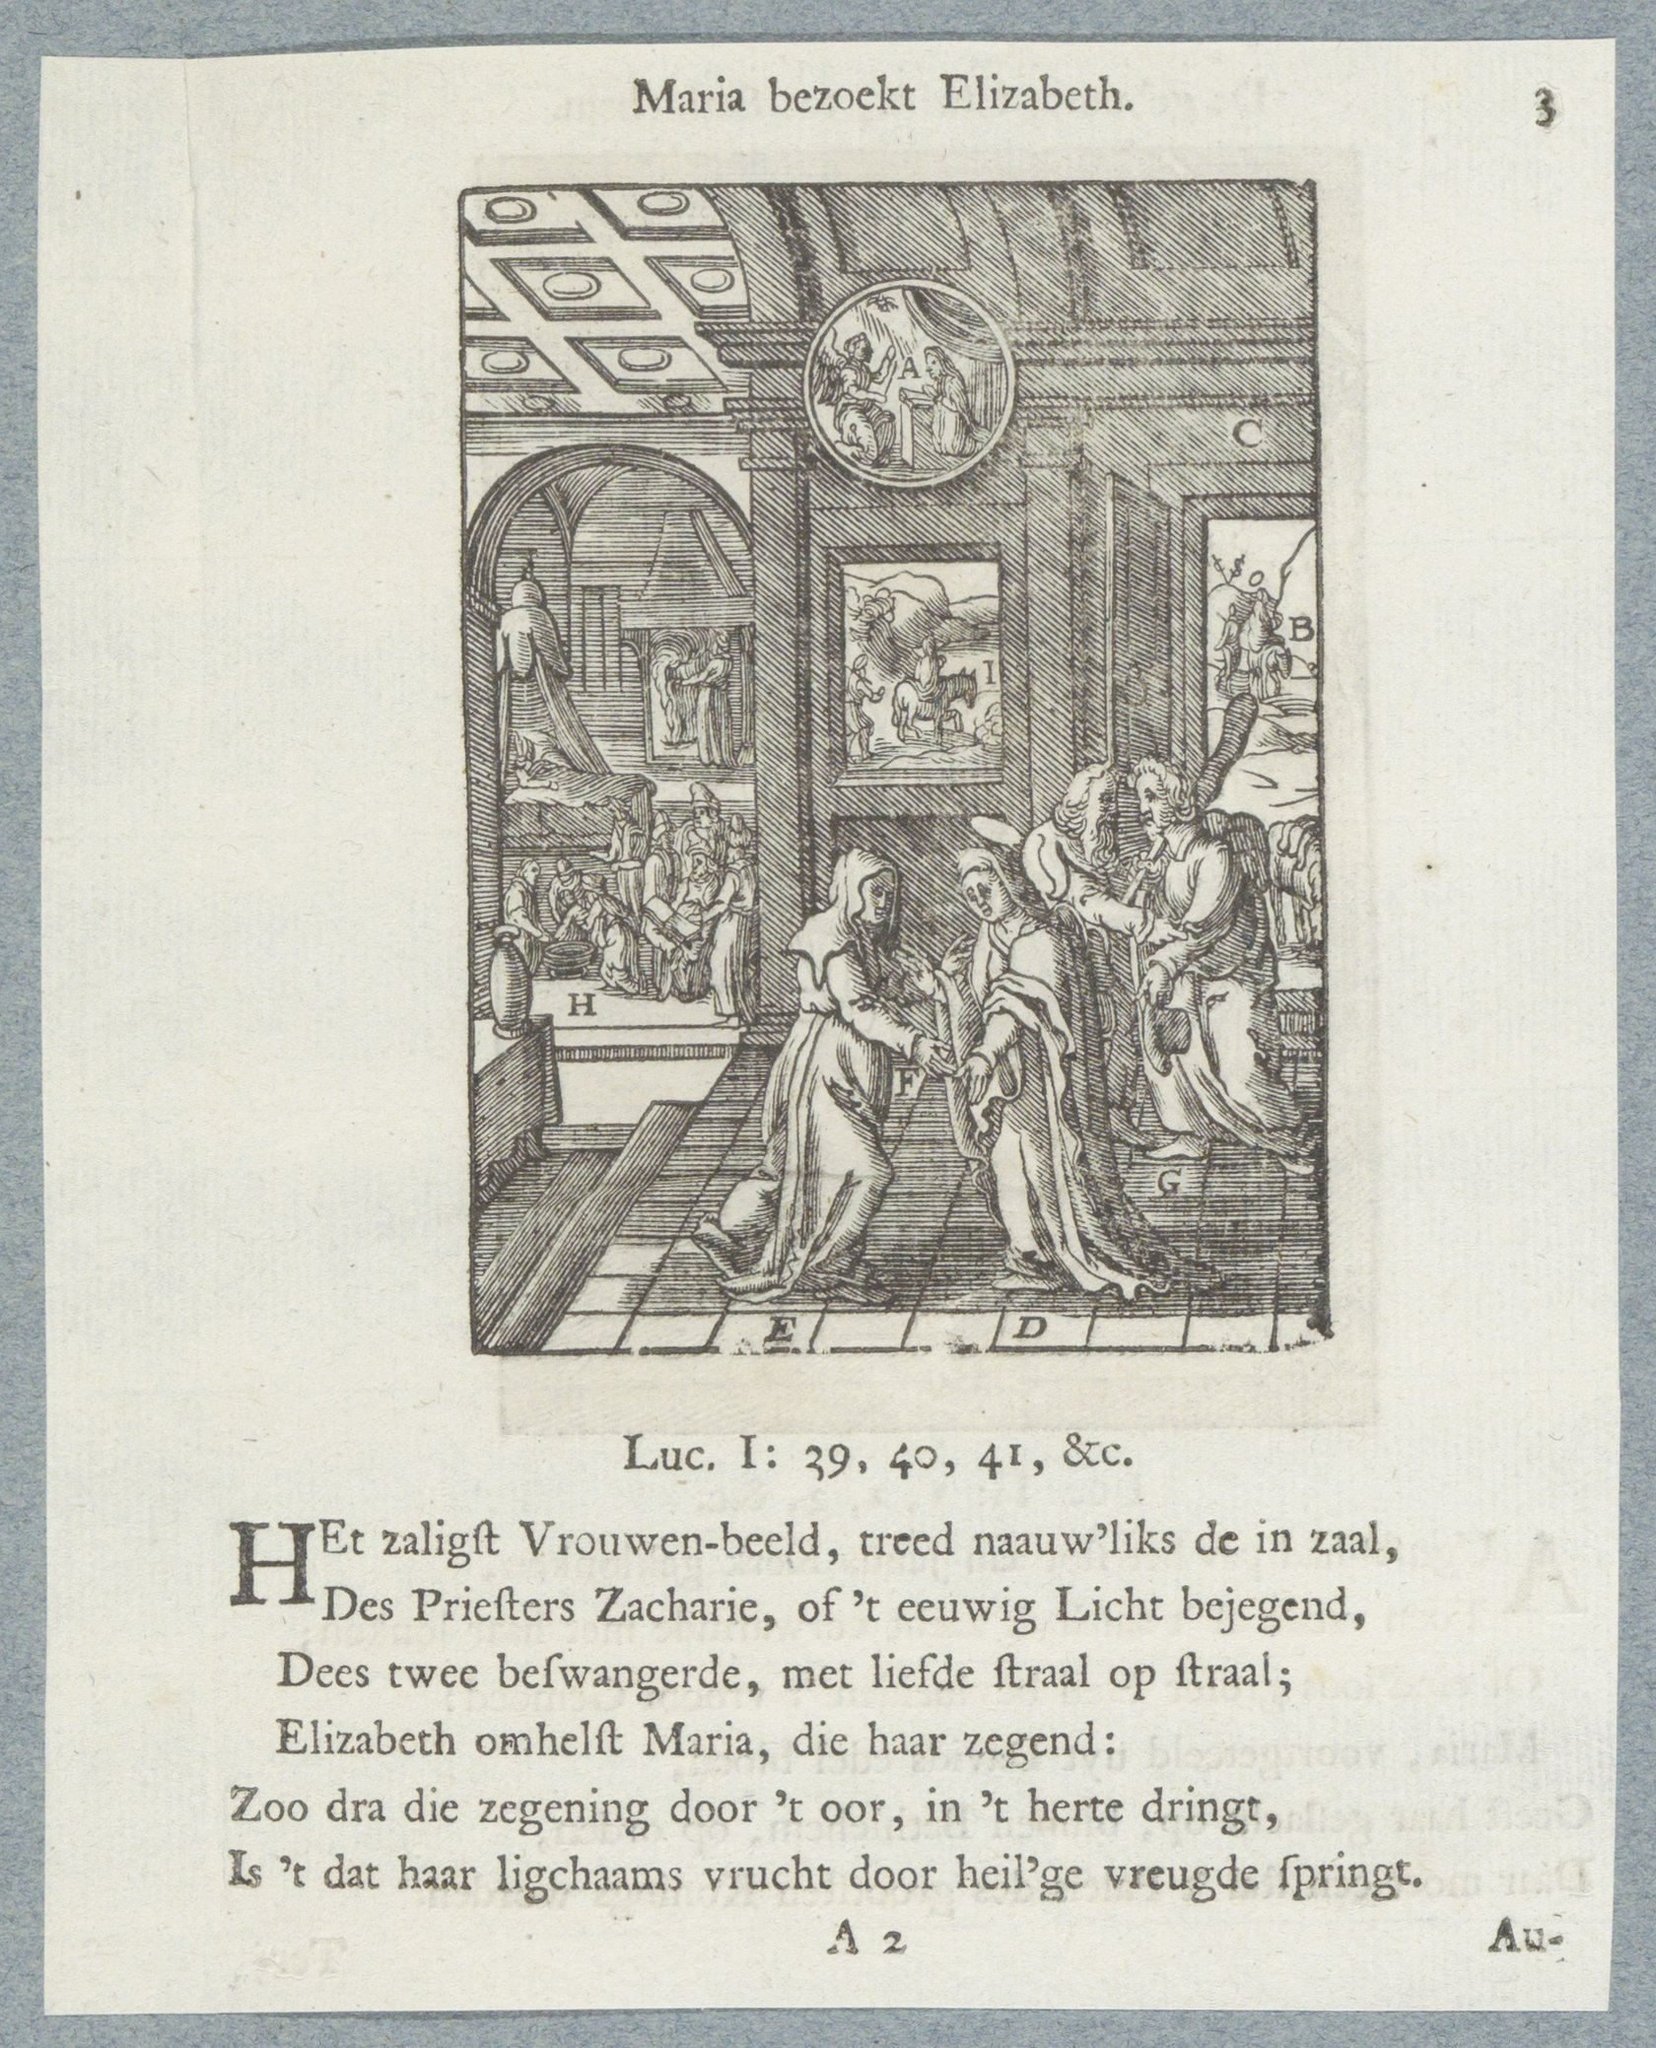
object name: print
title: Visitatie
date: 1629-1648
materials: paper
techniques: letterpress printing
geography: antwerp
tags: the flight into egypt: mary, joseph, the child (and sometimes others) on their way; mary usually riding on an ass, visitation (possibly joseph and/or zacharias present) (luke 1:39-56), birth of john the baptist, sometimes mary present, the annunciation: mary, usually reading, is visited by the angel (sometimes a woman overhears the conversation)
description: Maria bezoekt haar nicht Elisabet. In de deuropening Zacharias en Jozef. Links op de achtergrond de geboorte van Johannes de Doper. Door het venster is te zien hoe Jozef en Maria vluchten naar Egypte. Boven het venster een medaillon met de annunciatie. Bij verschillende elementen uit de voorstelling staan letters. Boven de voorstelling een titel. Eronder zes versregels en een verwijzing naar Lucas 1: 39-41. De prent maakt deel uit van een album.